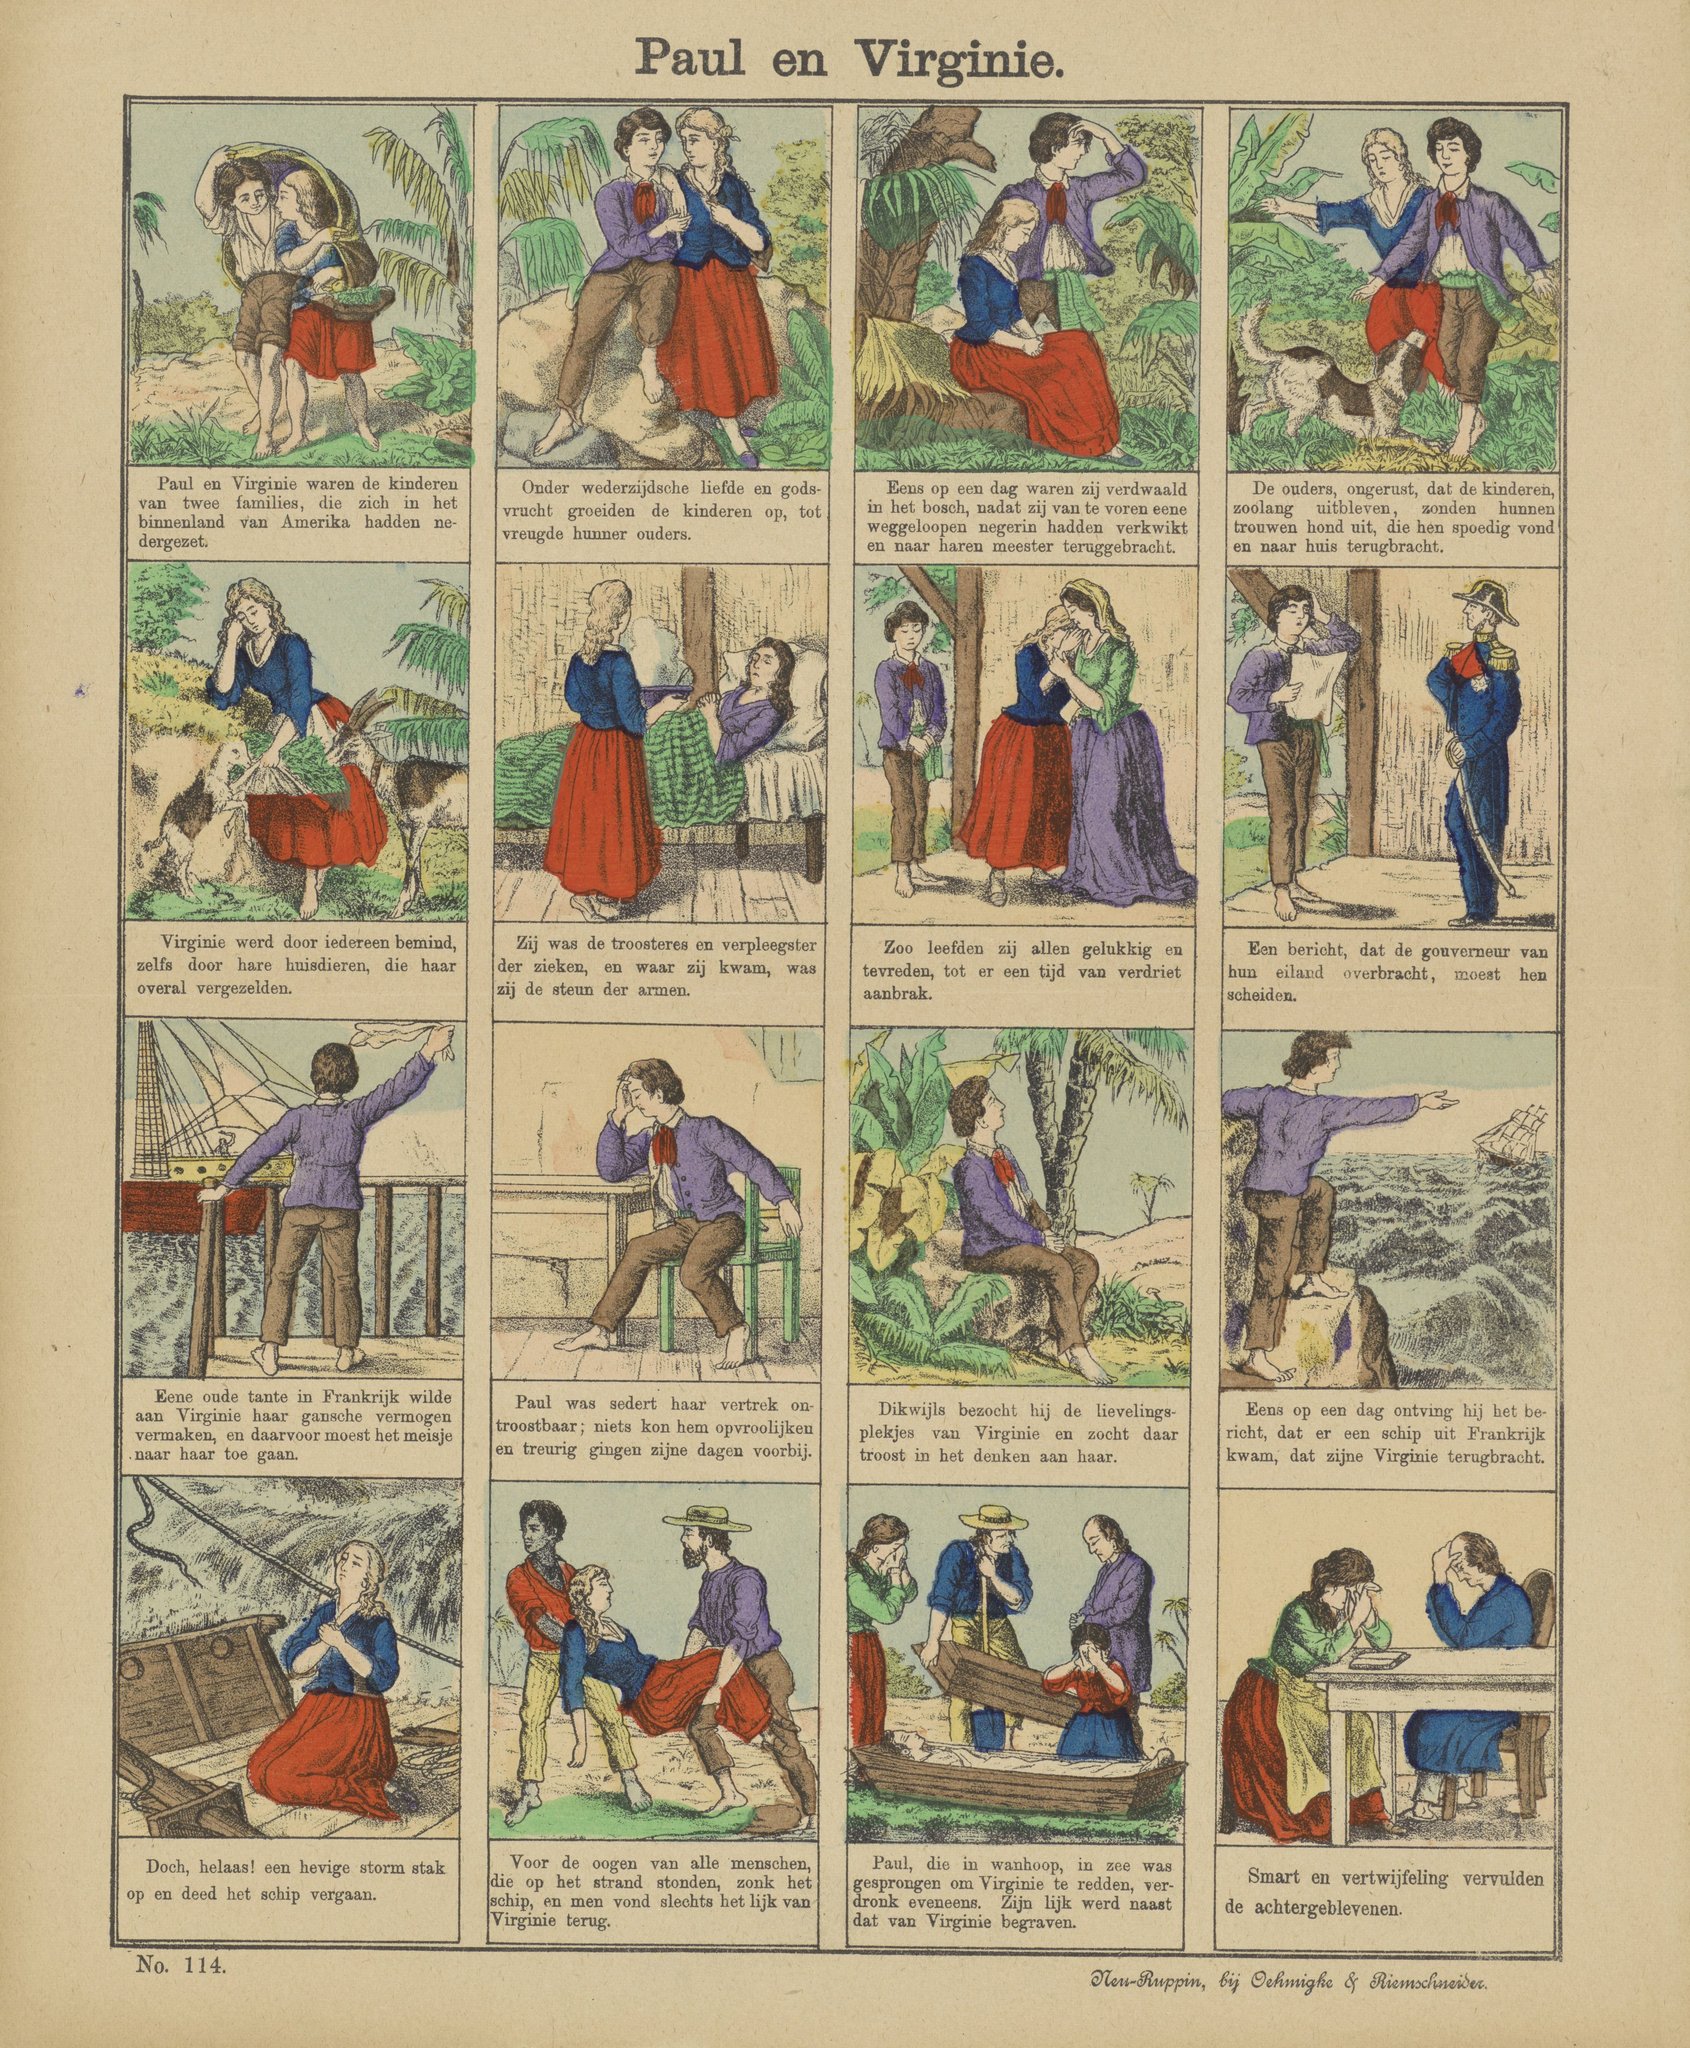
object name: print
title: Paul en Virginie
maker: Anonymous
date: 1828-1937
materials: paper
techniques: hand coloring, letterpress printing, lithograph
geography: neuruppin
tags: (scenes from) specific works of literature: bernardin de saint-pierre, paul et virginie, drowning, shipwrecked person, tales and fairy tales, death by drowning (non-violent)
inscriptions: collector's mark: Lugt 2760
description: Blad met 16 voorstellingen uit het verhaal van Paul en Virginie door Jacques-Henri Bernardin de Saint-Pierre. Onder elke afbeelding een onderschrift. Genummerd linksonder: No. 114.